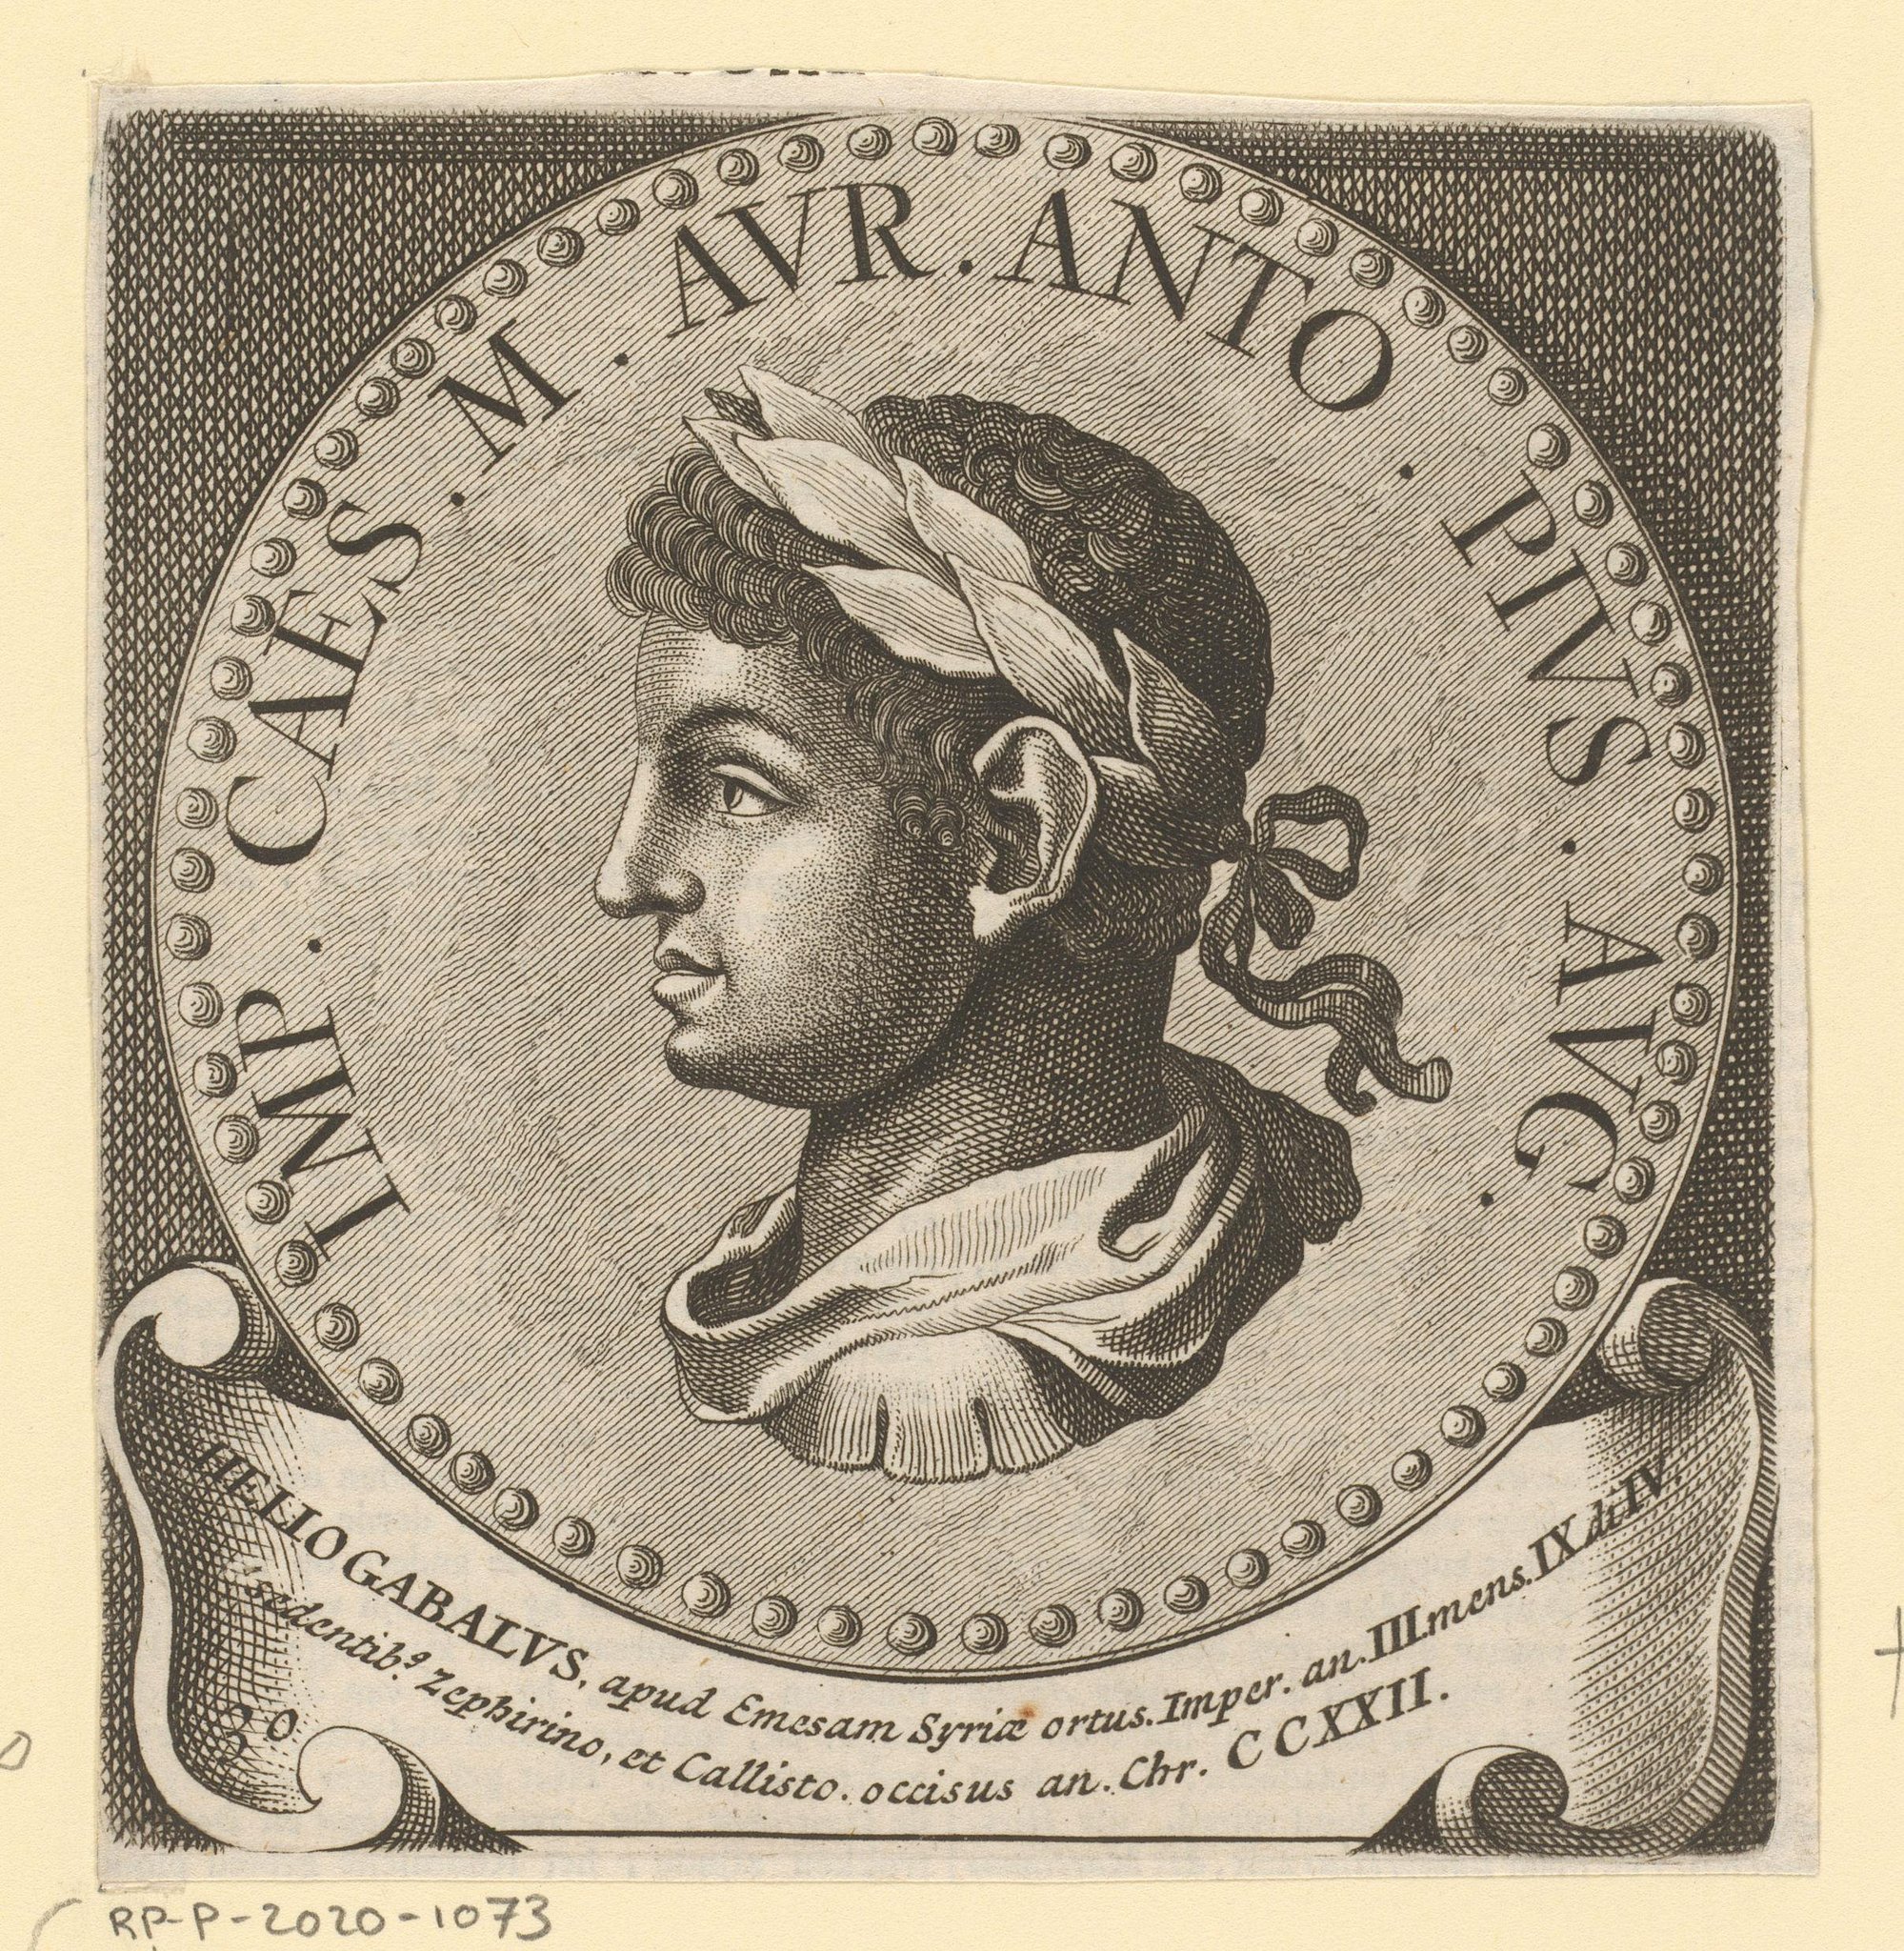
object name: print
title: Heliogabalus, apud Emesam Syriae ortus (...)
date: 1697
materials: paper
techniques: engraving, etching, letterpress printing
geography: utrecht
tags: historical persons, emperor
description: Prent uit: Bogaert, Abraham. De Roomsche monarchy, vertoont in de muntbeelden der westersche en oostersche keizeren (...). Utrecht: François Halma en Willem van de Water, 1697, p. 167. Eerste staat verschenen in een grotere prent met twaalf portretten, gedateerd 1695.